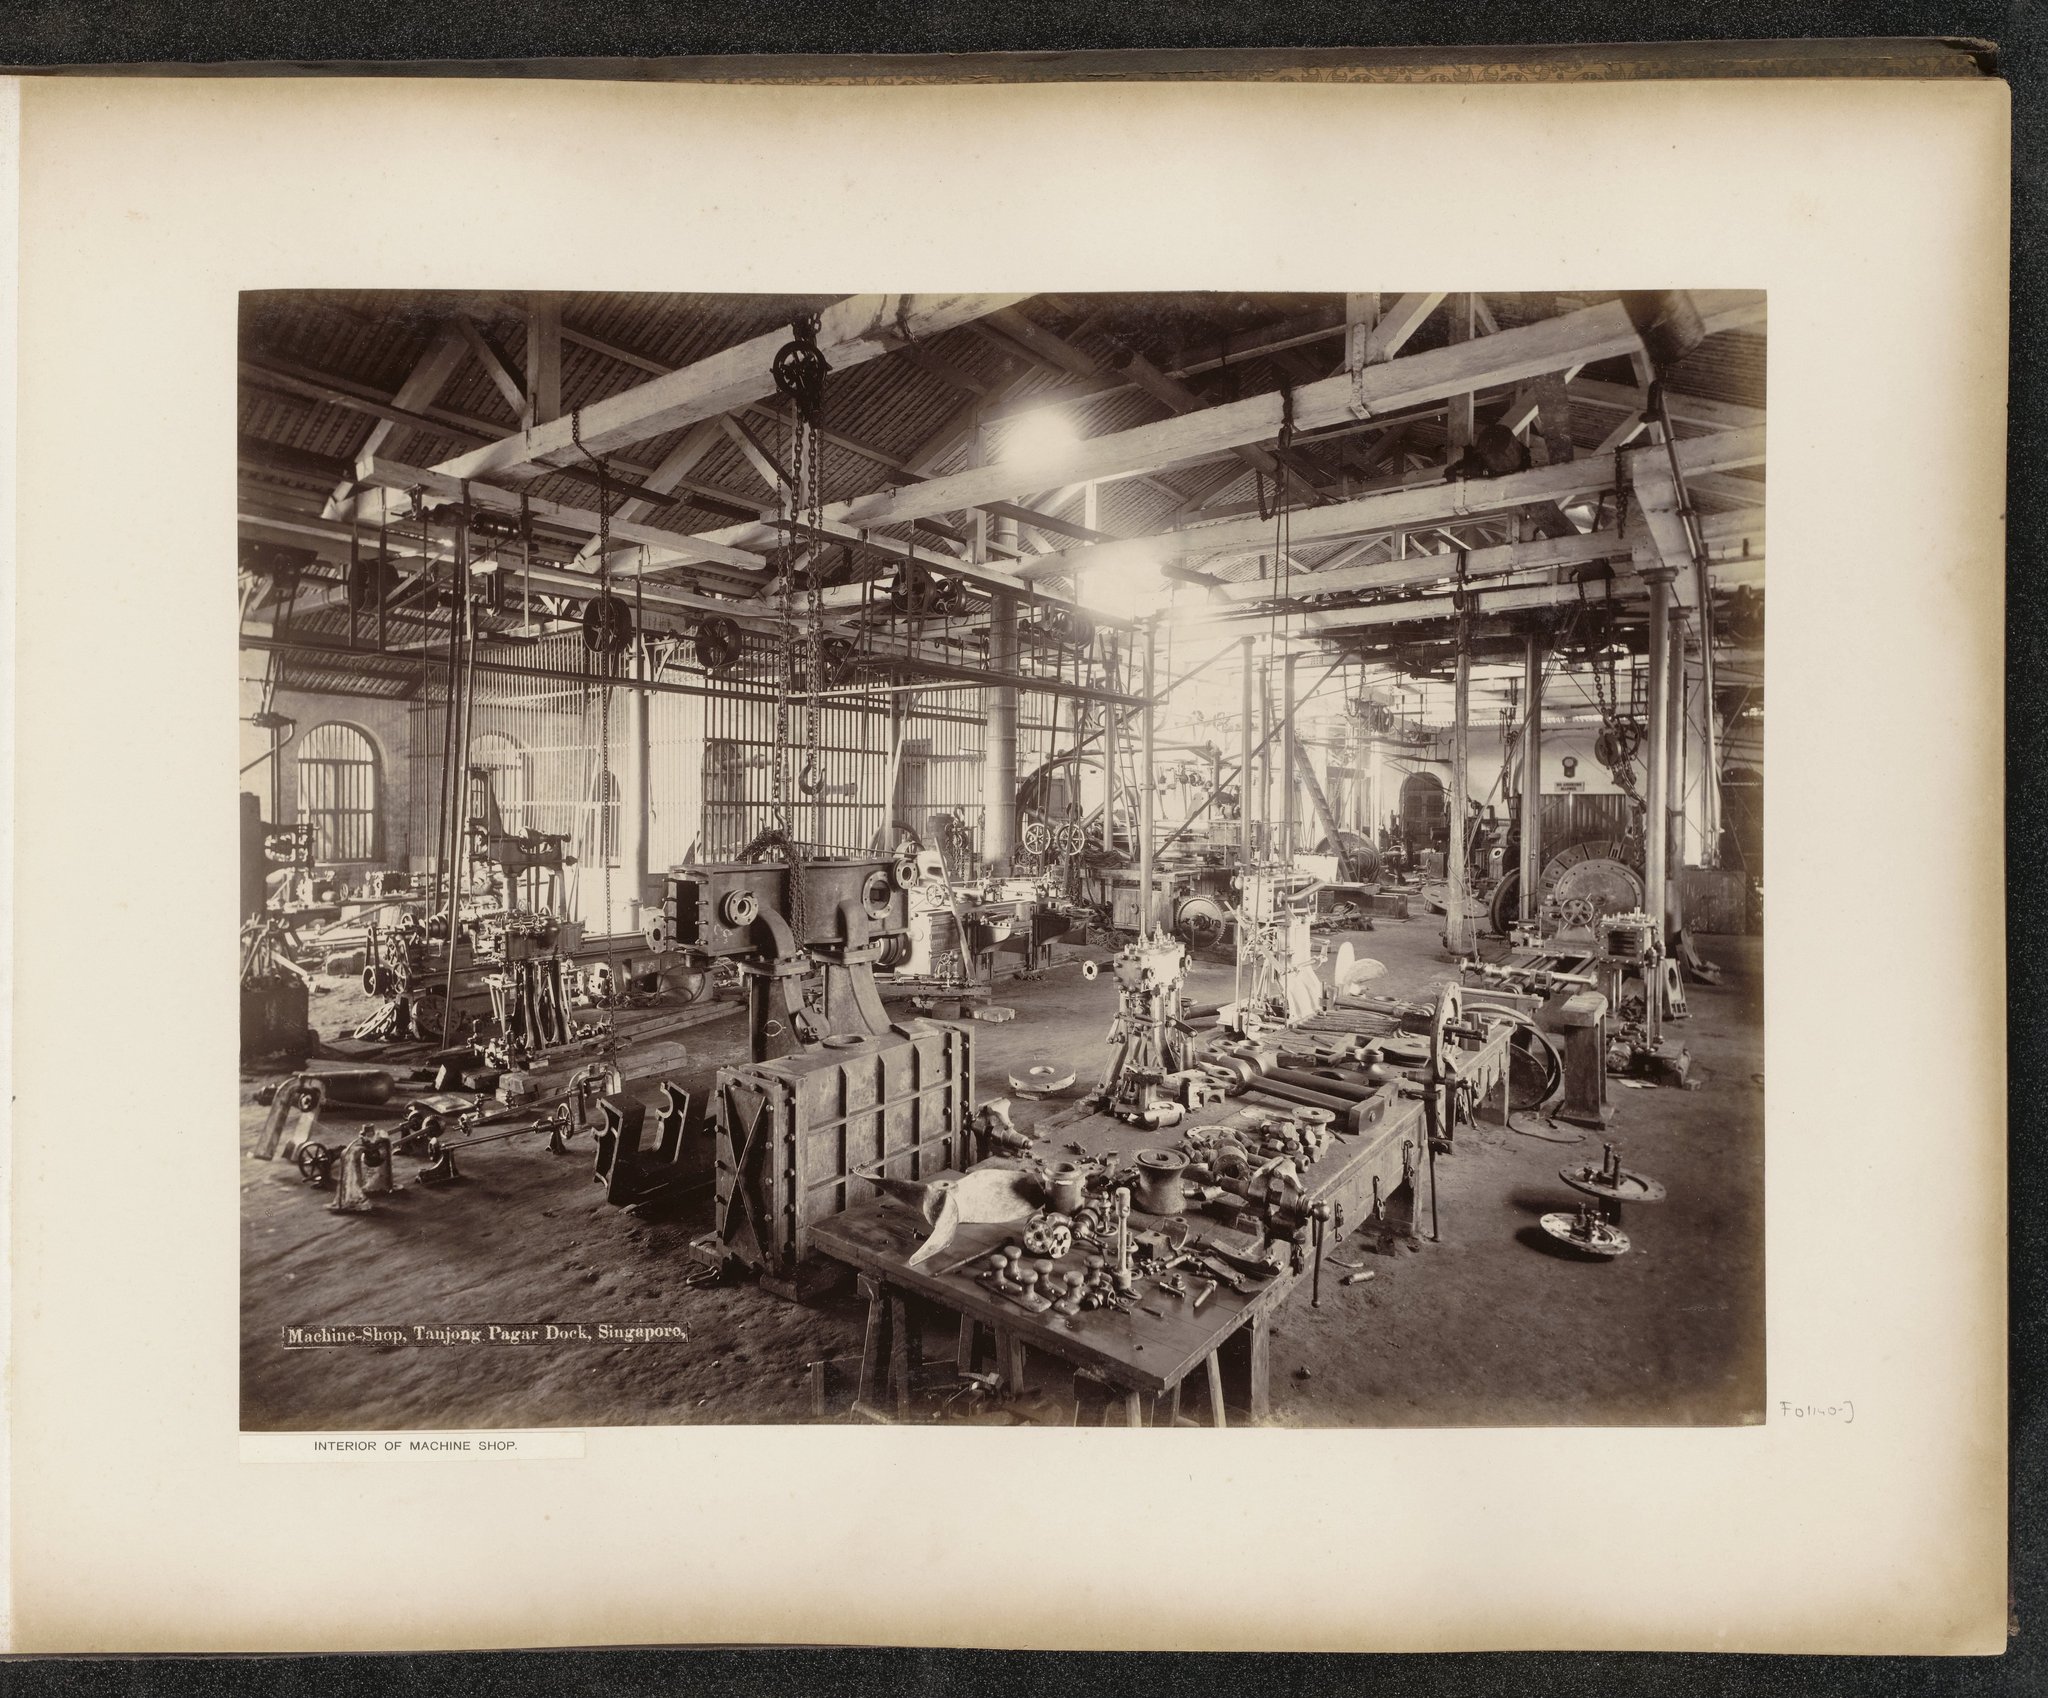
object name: photograph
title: Interior of machine shop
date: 1890-1905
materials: photographic support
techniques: albumen print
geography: singapore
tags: workbench, factory-interior, machine shop, pier, quay, wharf, shipyard, shipdock, workshop-interior, shipbuilding industry, singapore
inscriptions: inscription: ‘Machine-Shop, Tanjong. Pagar Dock. Singapore’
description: Onderdeel van Fotoalbum van de Tanjong Pagar Dock Co. Ltd. in Singapore.